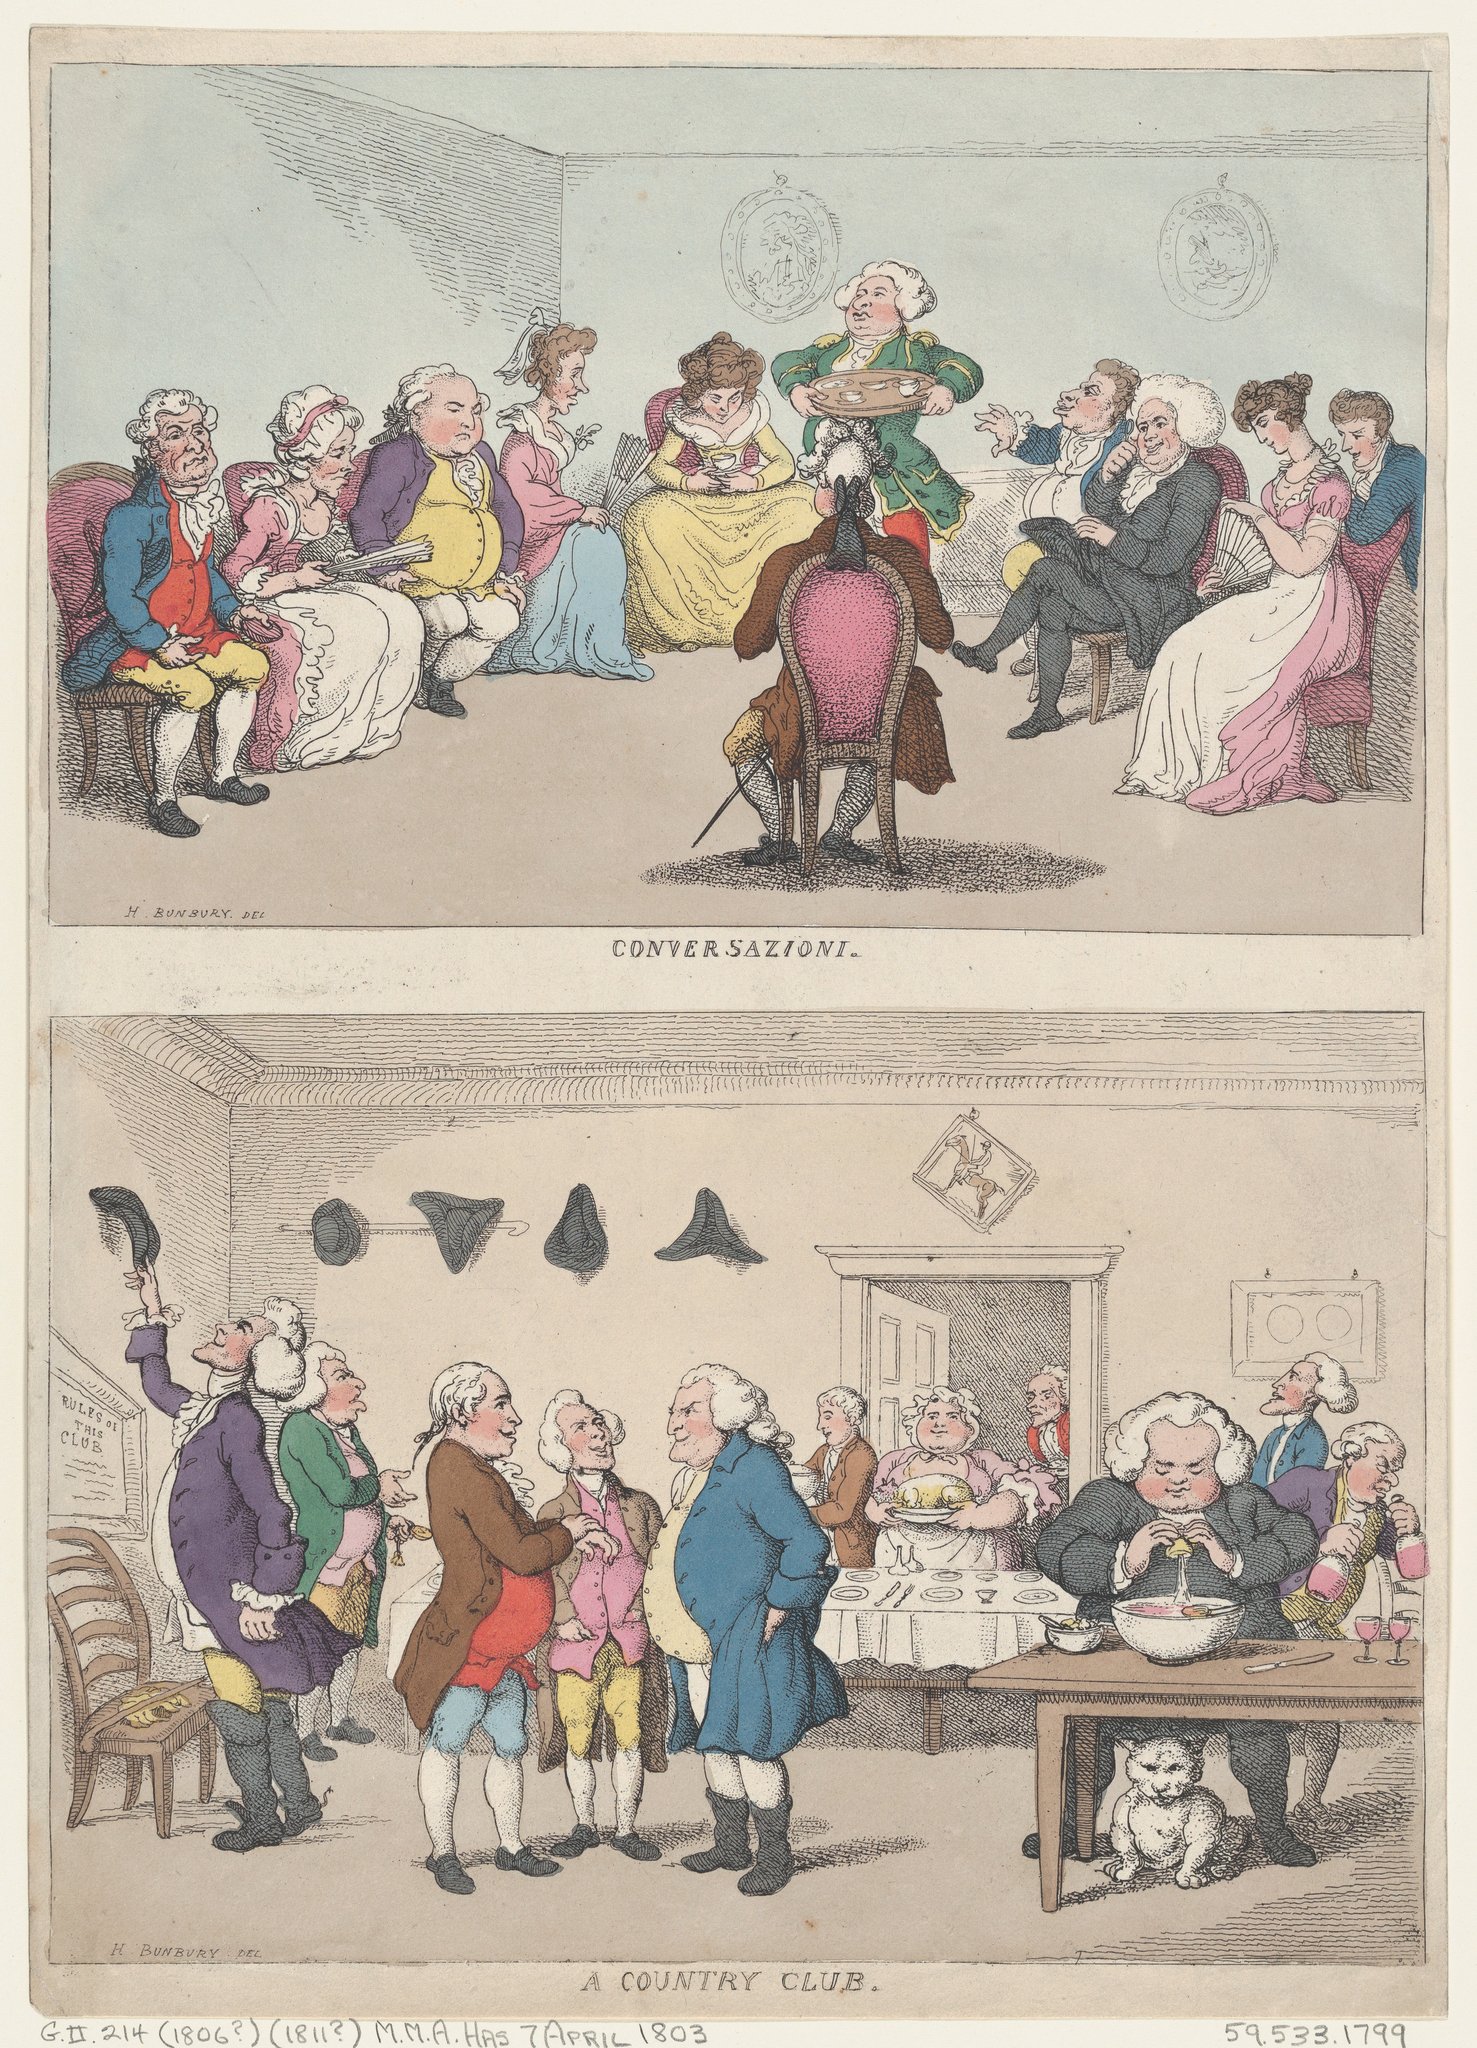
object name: print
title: Conversazione, and A Country Club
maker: thomas rowlandson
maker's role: artist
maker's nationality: british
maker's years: 1757-1827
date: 1806-1811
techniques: etching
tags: satire,men,women